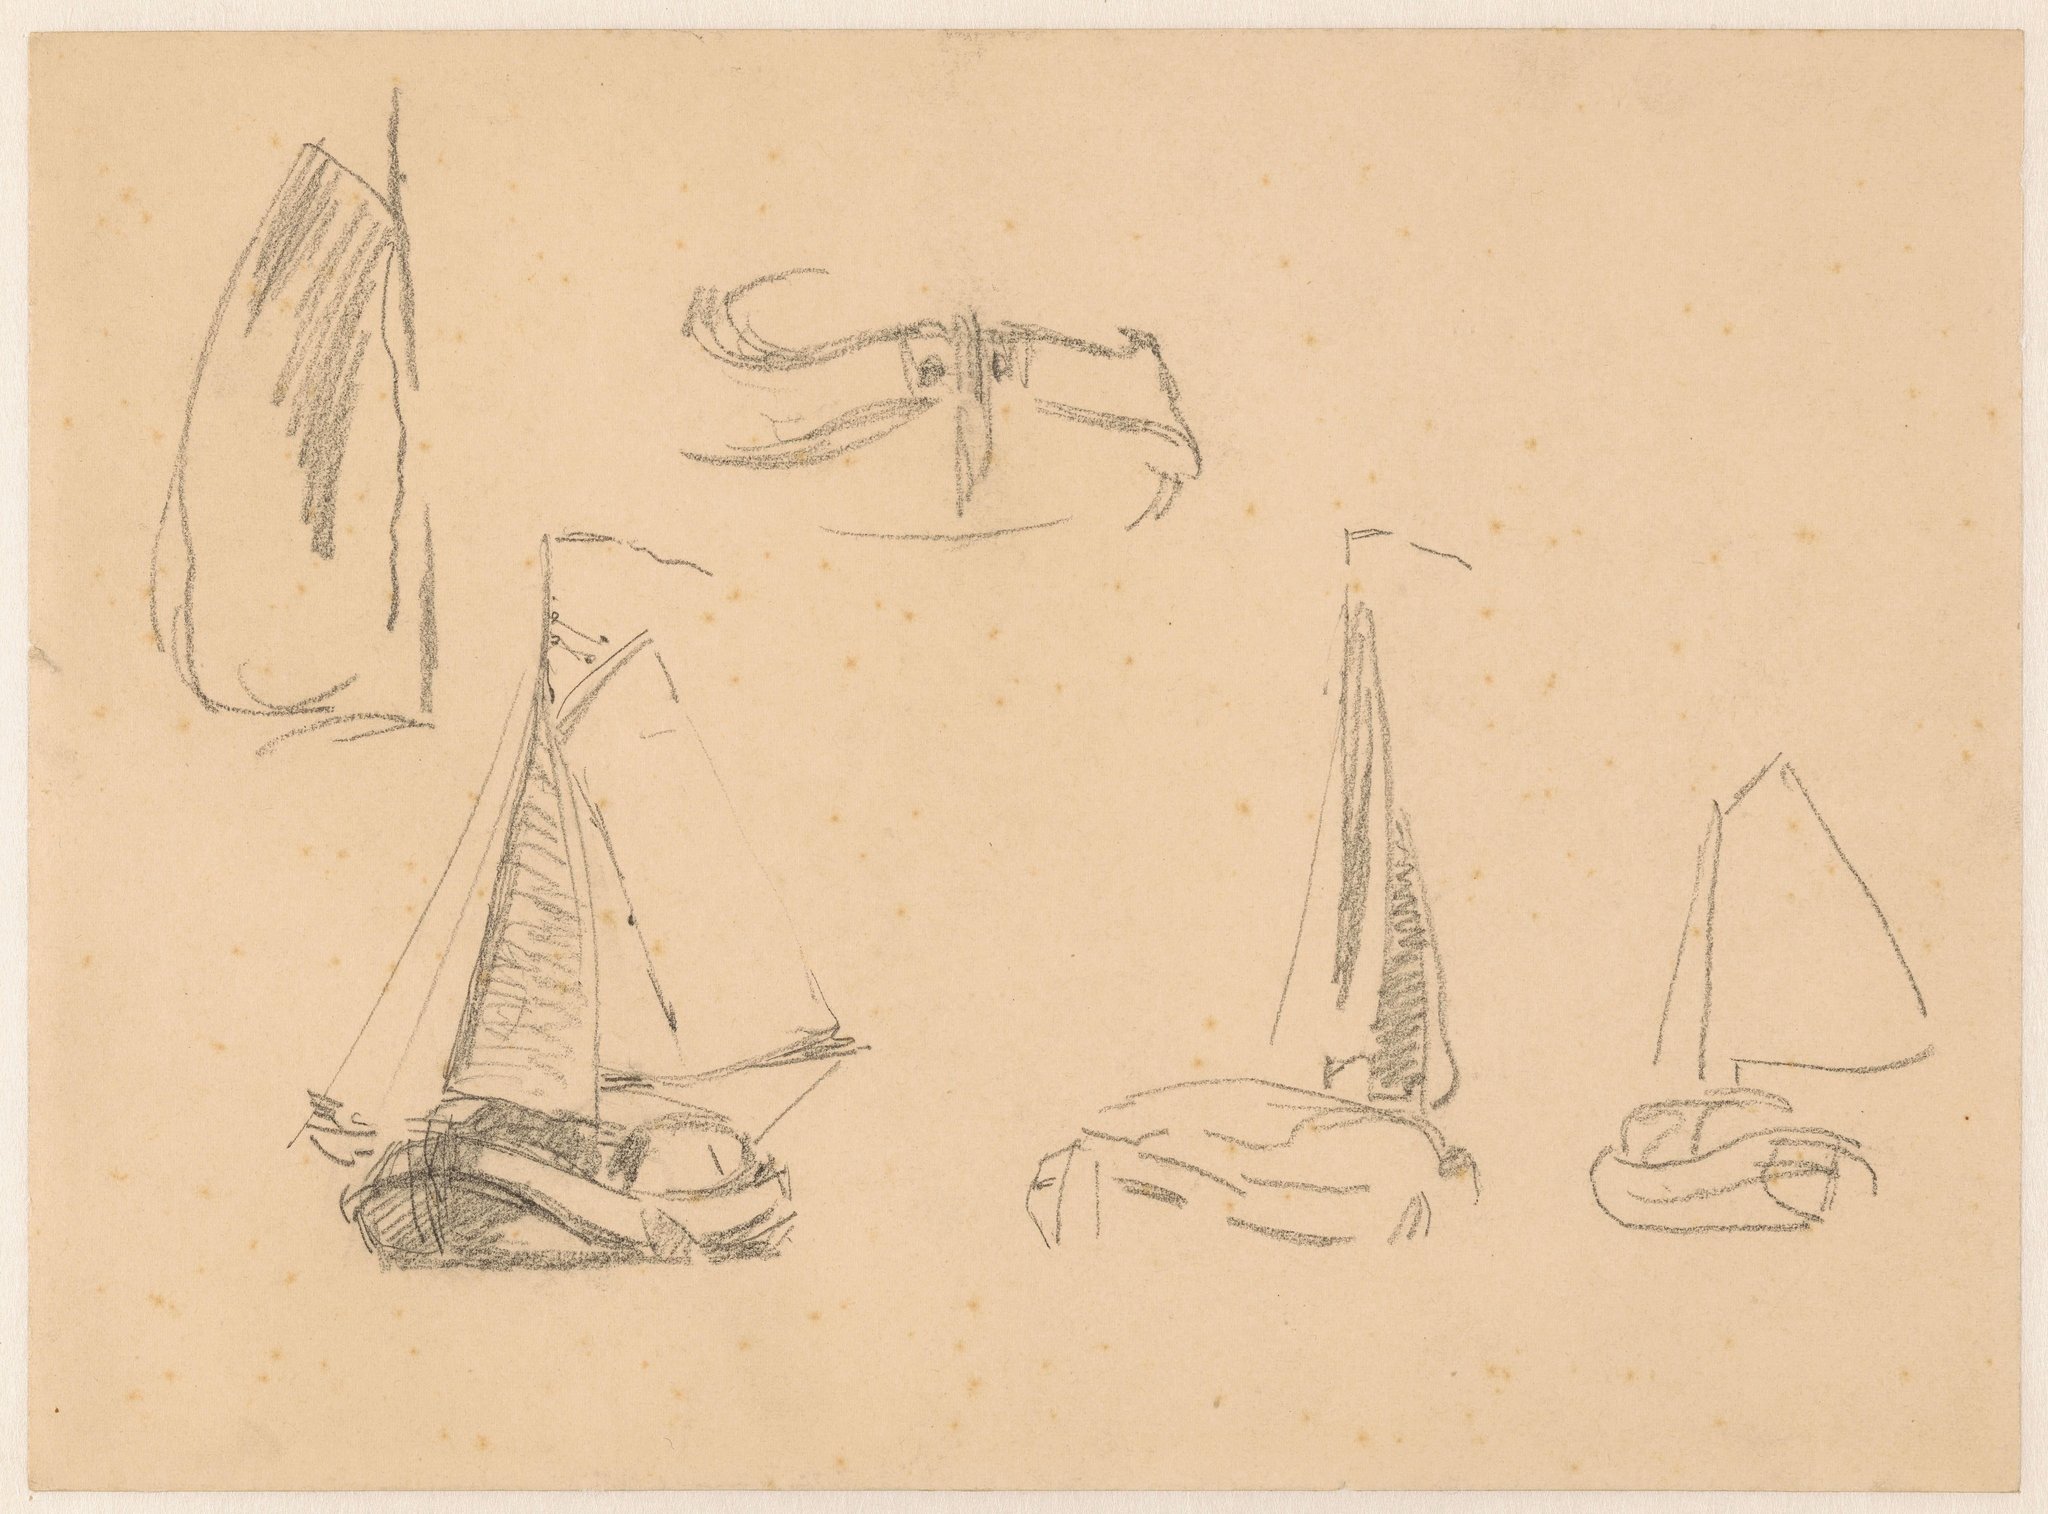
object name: drawing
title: Studieblad met diverse zeilschepen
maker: willem bastiaan tholen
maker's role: draughtsman, painter, print maker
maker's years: 1860-1931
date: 1870-1931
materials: chalk, paper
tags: ships (in general) - cc - more than one ship